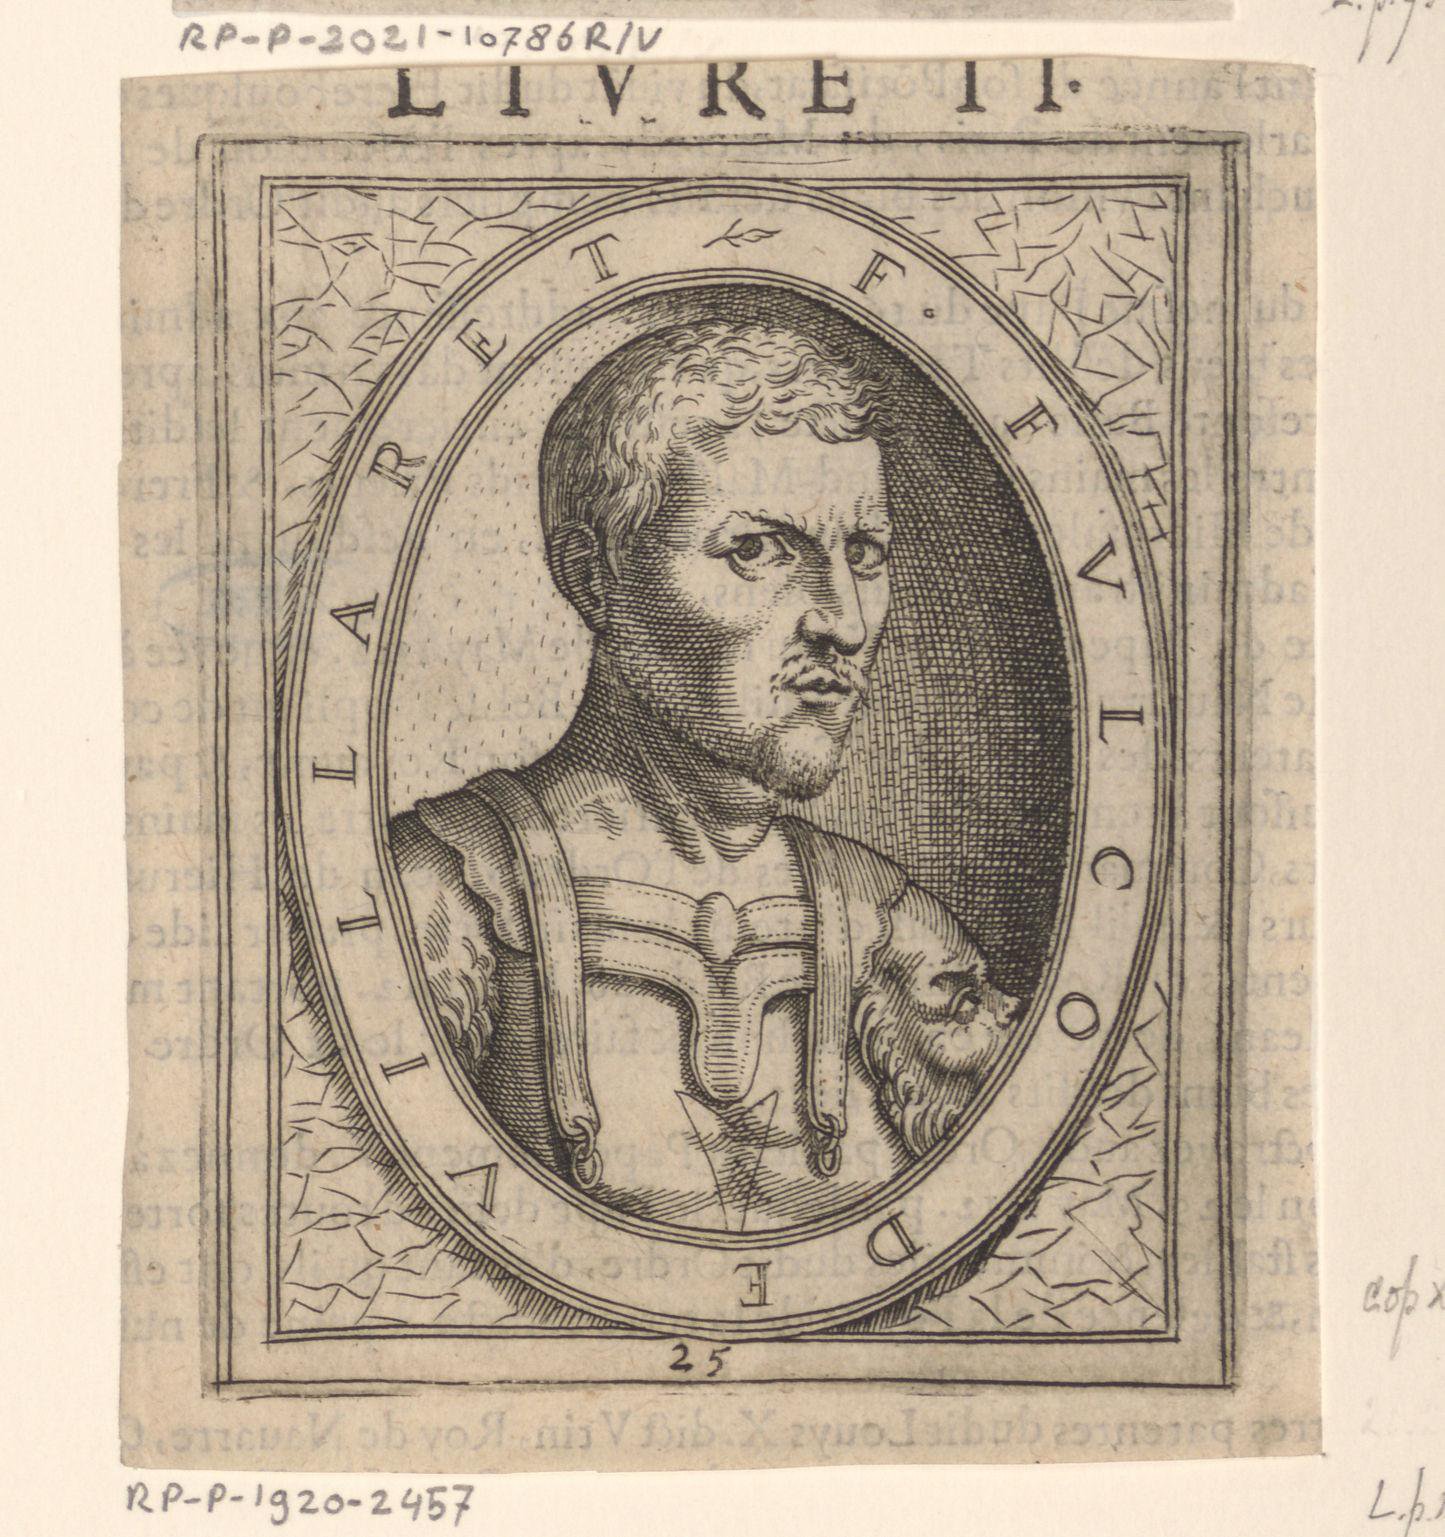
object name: print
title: Portret van Foulques de Villaret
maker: Anonymous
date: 1643-1659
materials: paper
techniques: engraving, letterpress printing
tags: historical persons, military orders, e.g.: knights templars, knights of malta, teutonic knights ~ roman catholic church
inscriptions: collector's mark: Lugt 2228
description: Prent mogelijk uit: Baudoin, Jean. Histoire des chevaliers de l'ordre de s. Jean de Hierusalem (...). Parijs: Jacques Dallin, 1643. Of uit: Baudoin, Jean. Histoire des chevaliers de l'ordre de s. Jean de Hierusalem (...). Parijs: Thomas Jolly, 1659.